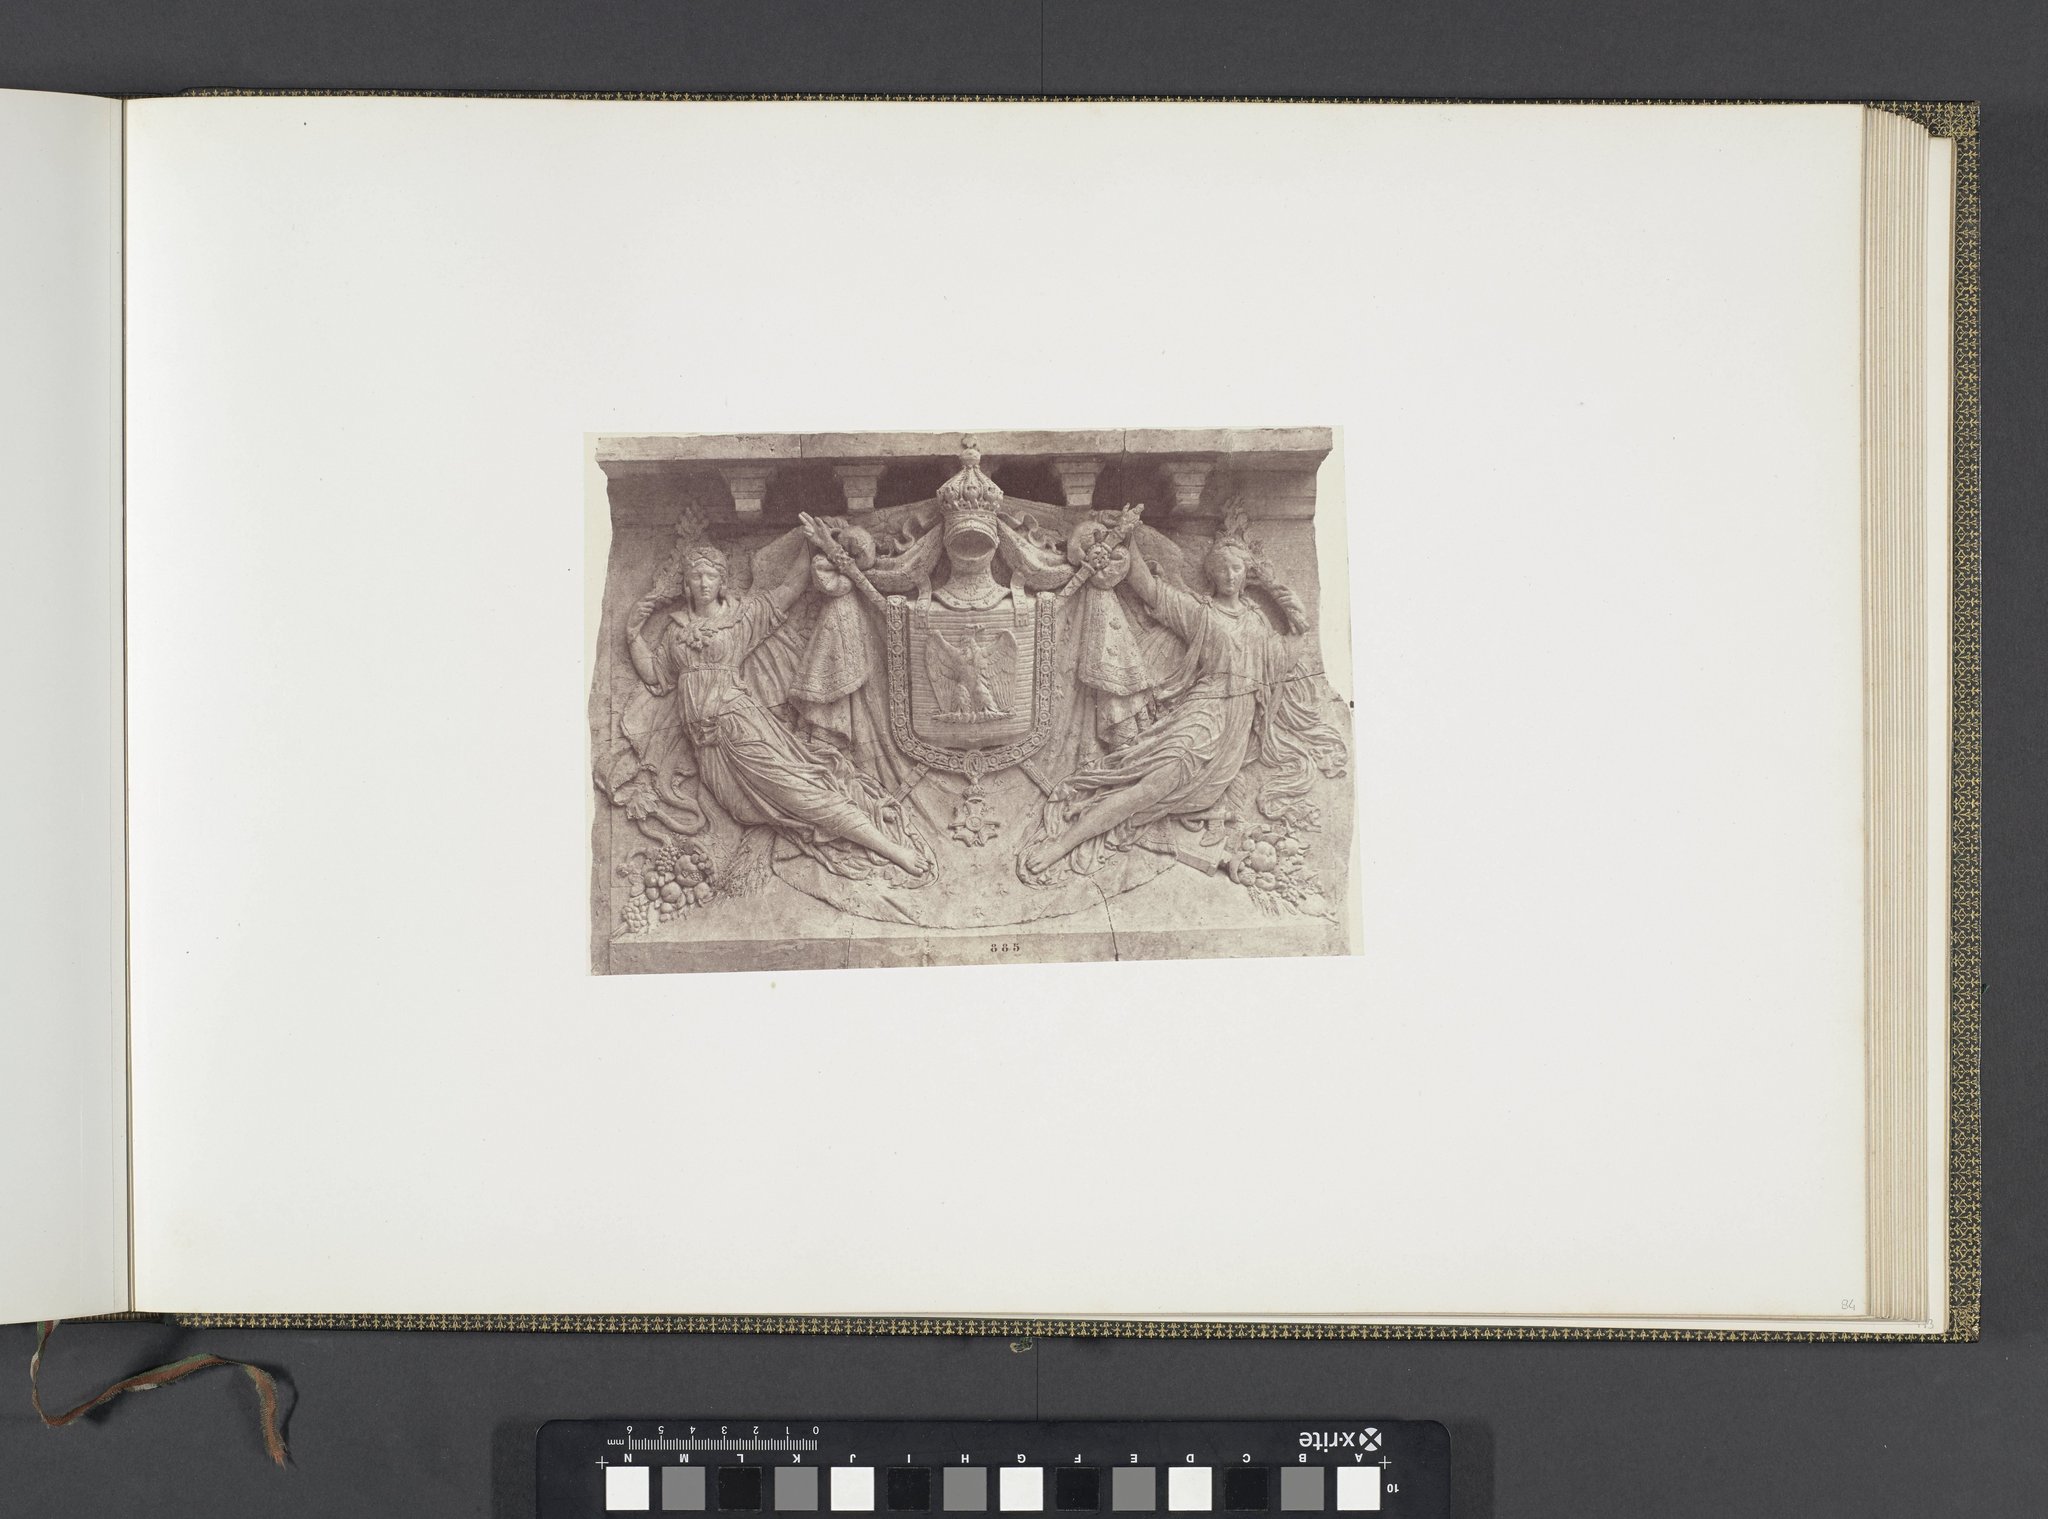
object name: photograph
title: Gipsmodel voor beeldhouwwerk op het Palais du Louvre: "Le Courage civique et la Gloire" door Théodore-Charles Gruyère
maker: édouard denis baldus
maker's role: fotograaf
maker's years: 1813-1889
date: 1855-1857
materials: paper, photographic support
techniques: salted paper print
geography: paris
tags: piece of sculpture, reproduction of a piece of sculpture, permanent exhibition, museum, paris, tuileries palace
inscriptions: number: ‘885’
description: Onderdeel van Réunion des Tuileries au Louvre 1852-1857, album 1.